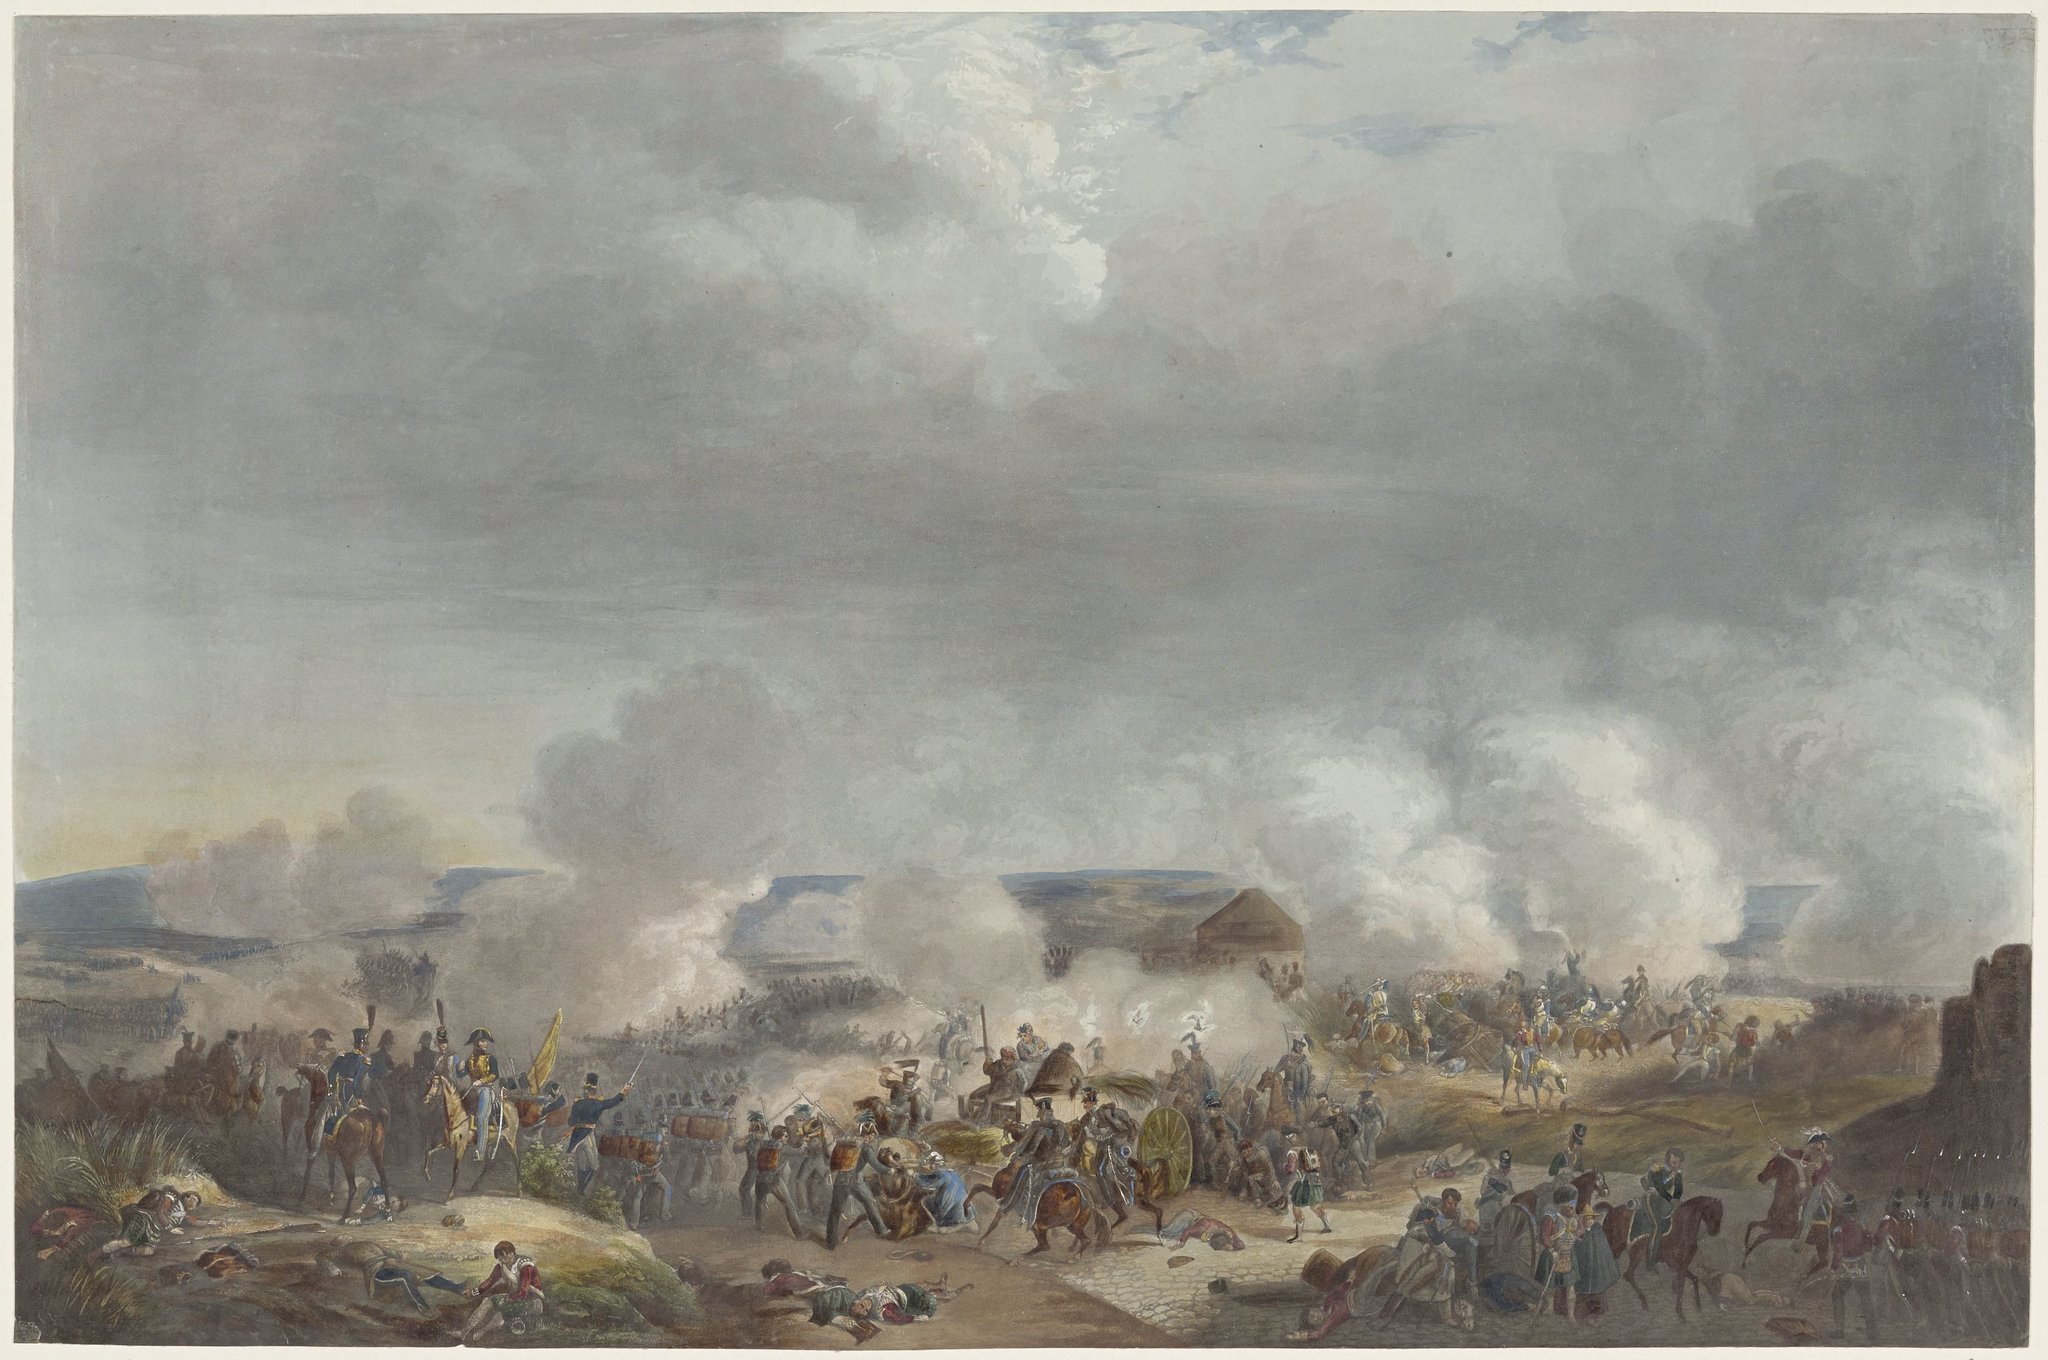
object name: history print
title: Prins van Oranje in de slag bij Quatre-Bras, 1815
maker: johann hürlimann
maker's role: print maker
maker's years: 1793-1850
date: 1825-1826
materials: paper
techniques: aquatint, etching, hand coloring, lacquer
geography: brussels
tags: the hague, william ii of the netherlands, battle (+ land forces)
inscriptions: collector's mark: Lugt 2228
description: De prins van Oranje te paard overziet het slagveld tijdens de slag bij Quatre-Bras, 16 juni 1815. Links de prins te paard op een heuveltje omgeven door zijn staf. Centraal gevechten rondom een boerenwagen. Rechts gevechten tussen Bergschotten en Franse kurassiers. Centraal onderaan het wapen van koning Willem I. Behoort bij een serie platen over de inhuldiging van Willem I in Brussel.